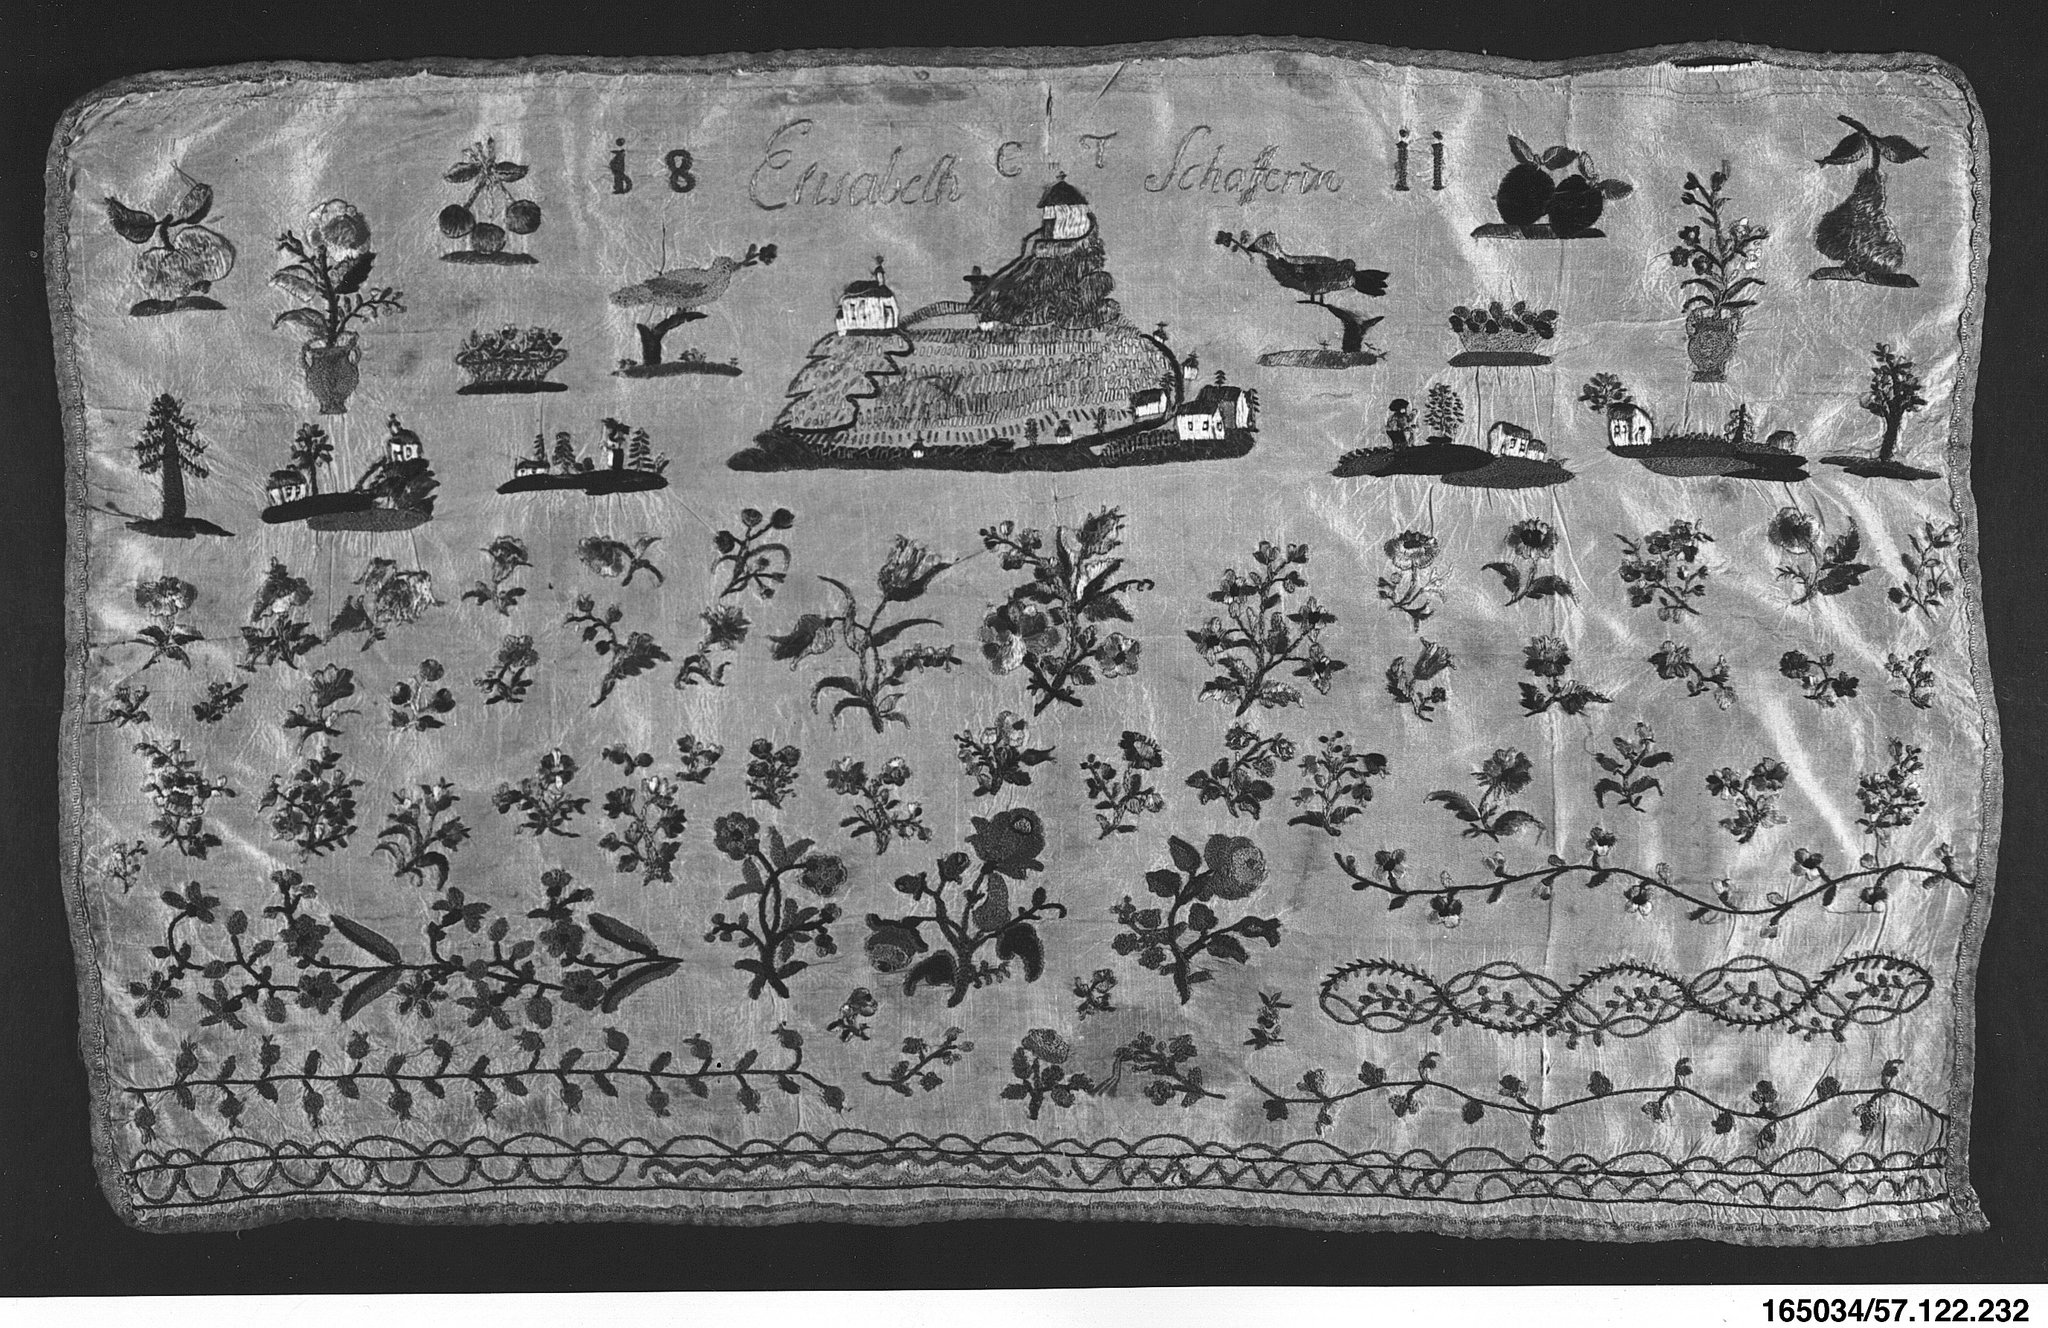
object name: sampler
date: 1811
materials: silk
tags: birds,houses,flowers